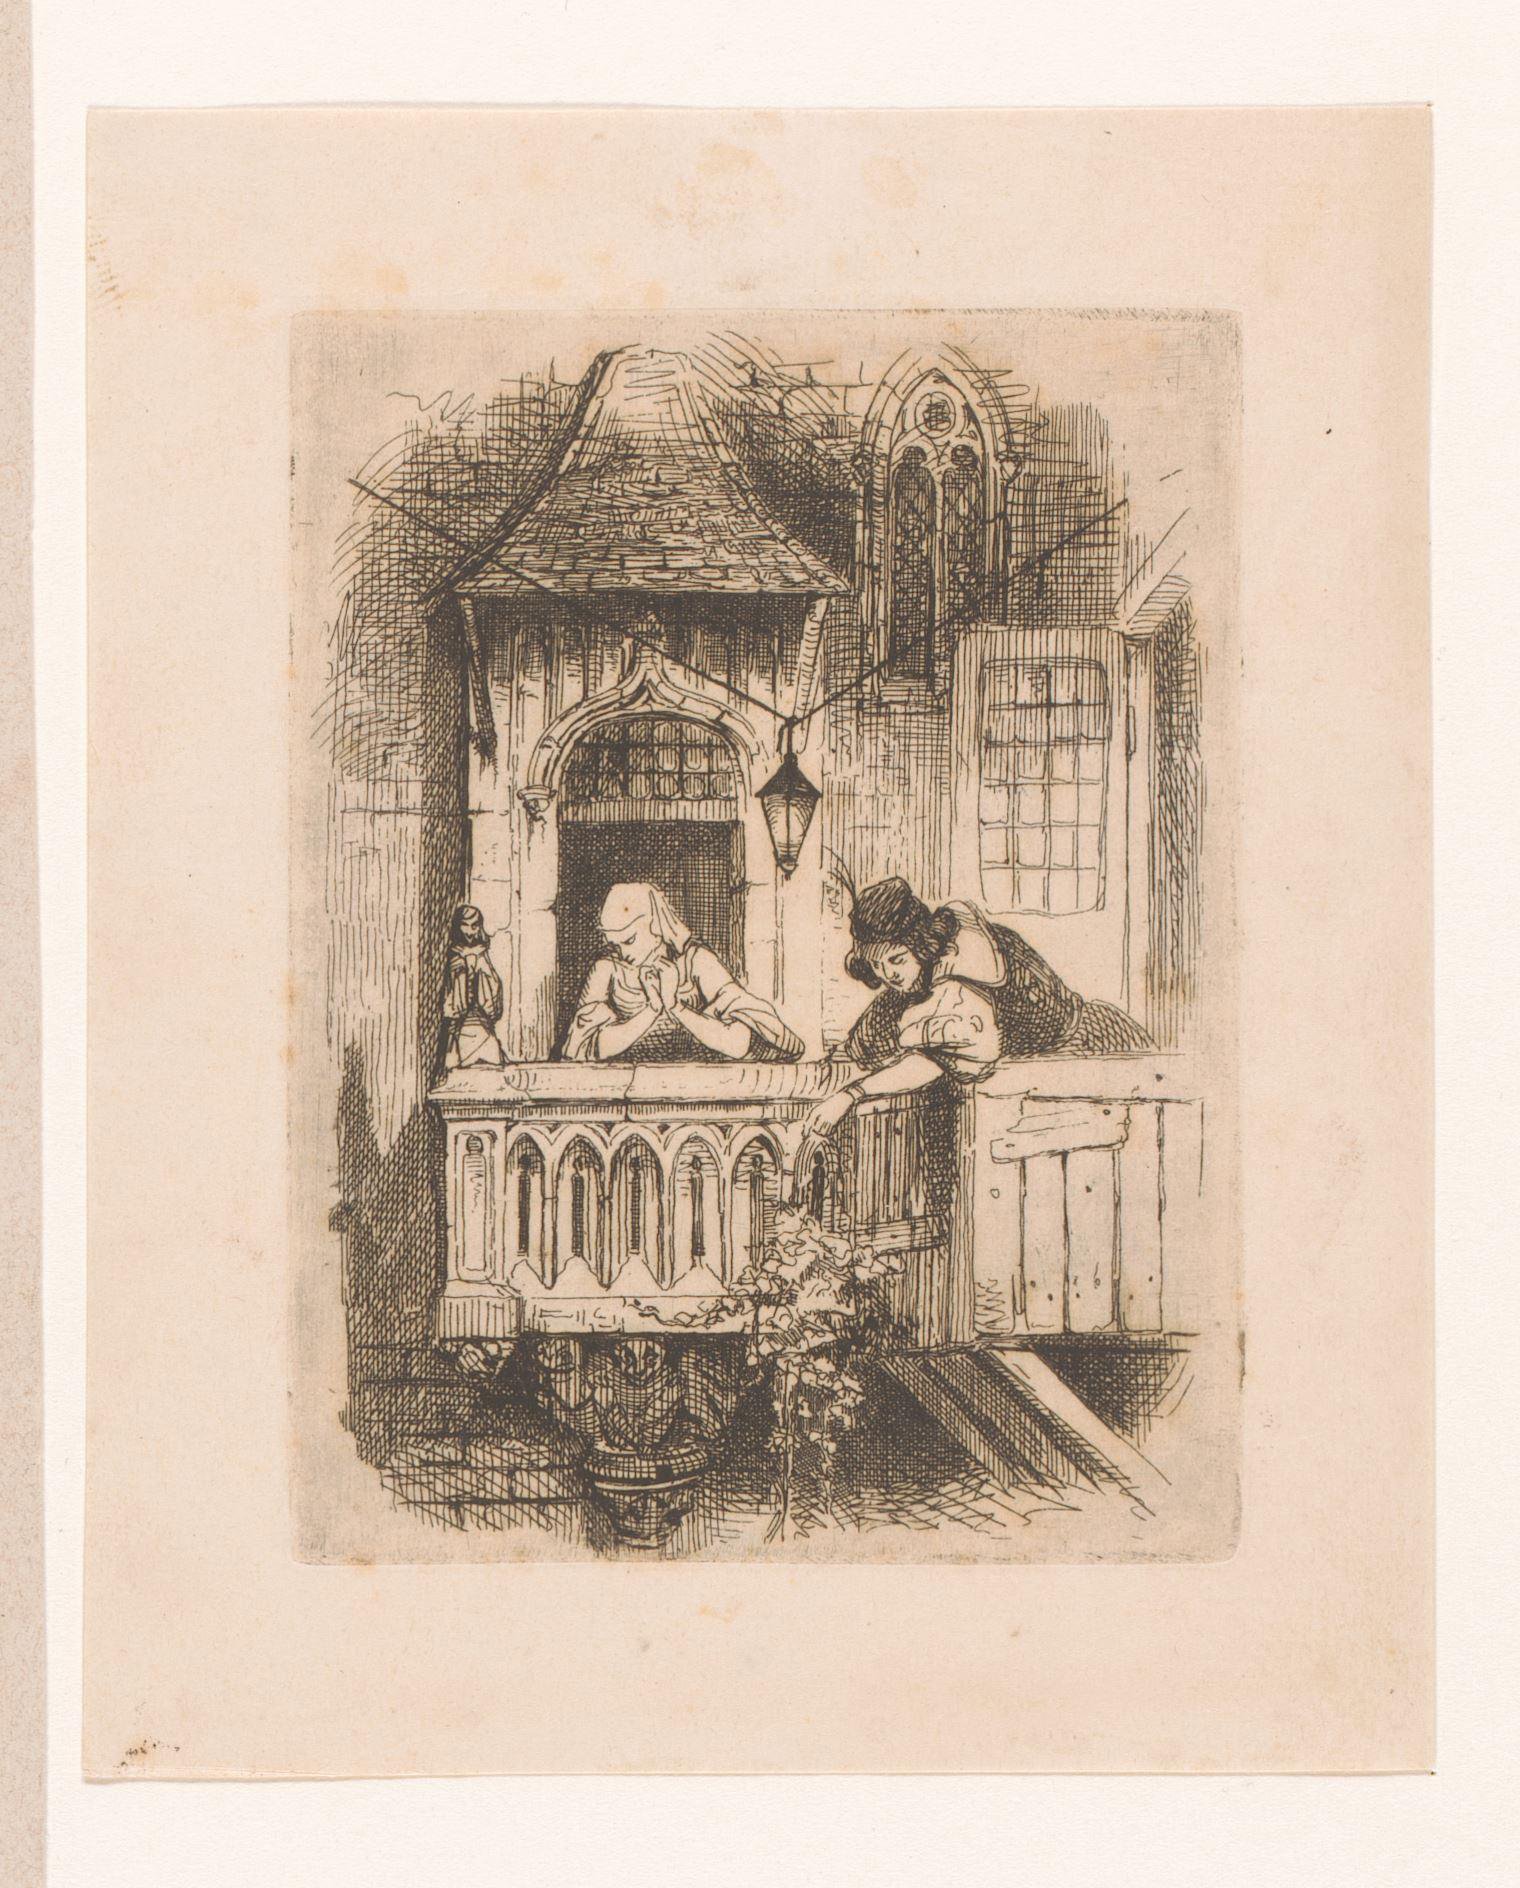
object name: print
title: Man en vrouw leunen over de rand van een balkon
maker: corneille seghers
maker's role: draughtsman, print maker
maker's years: 1814-1869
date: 1824-1869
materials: paper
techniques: etching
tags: leaning forward, balcony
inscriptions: collector's mark: Lugt 1485, collector's mark: Lugt 2228